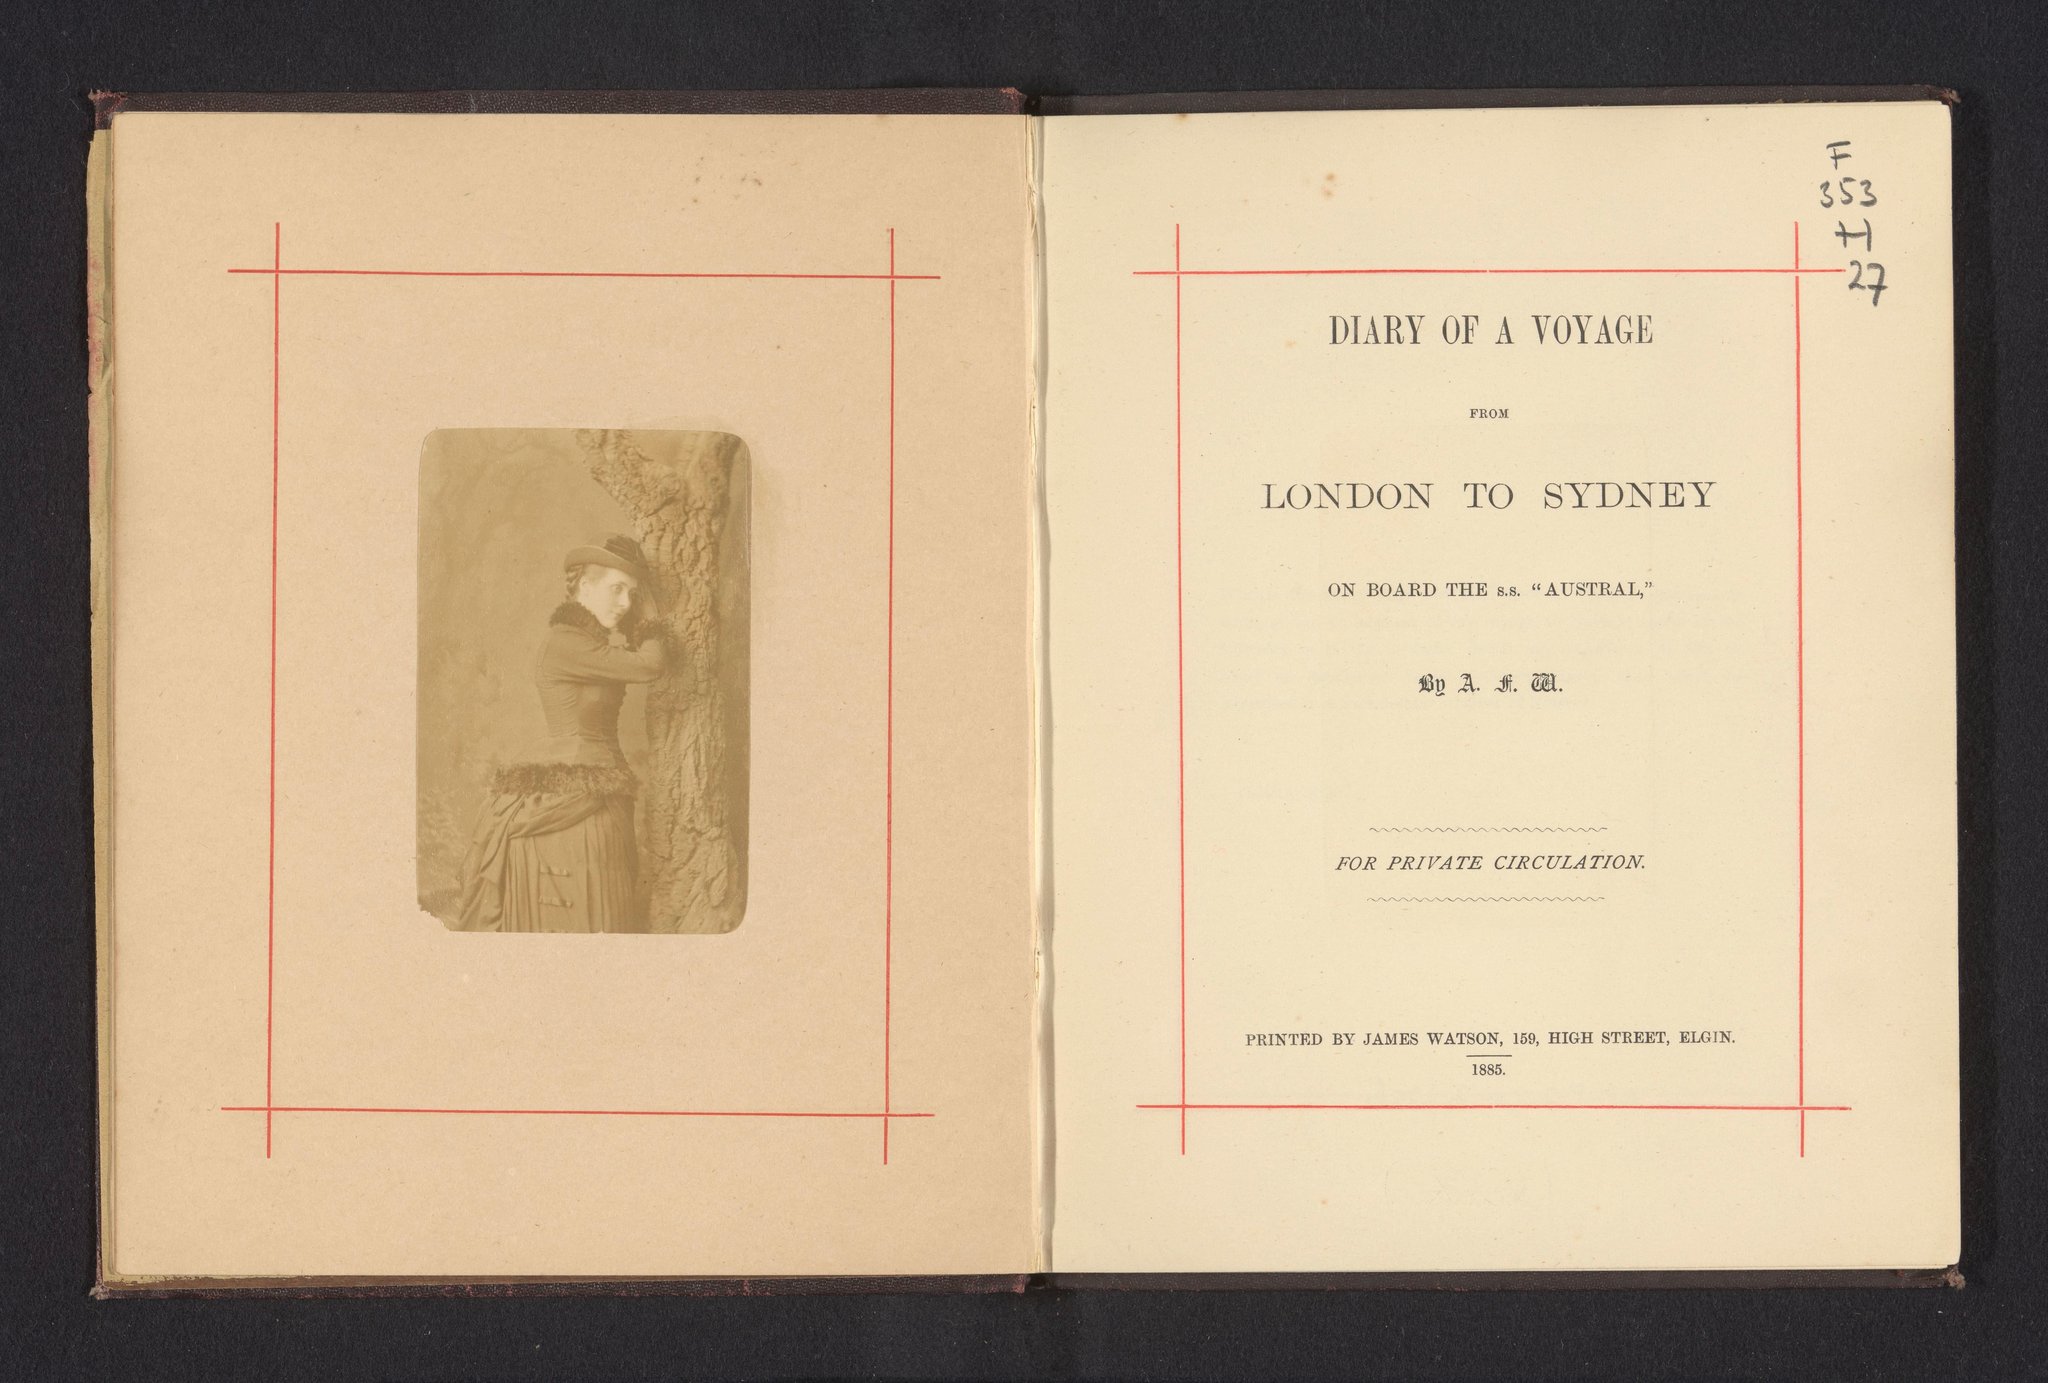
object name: book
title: Diary of a voyage from London to Sydney on board the s.s. Austral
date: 1885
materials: cardboard, linen, paper, photographic support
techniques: albumen print, decorated paper, printing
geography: elgin